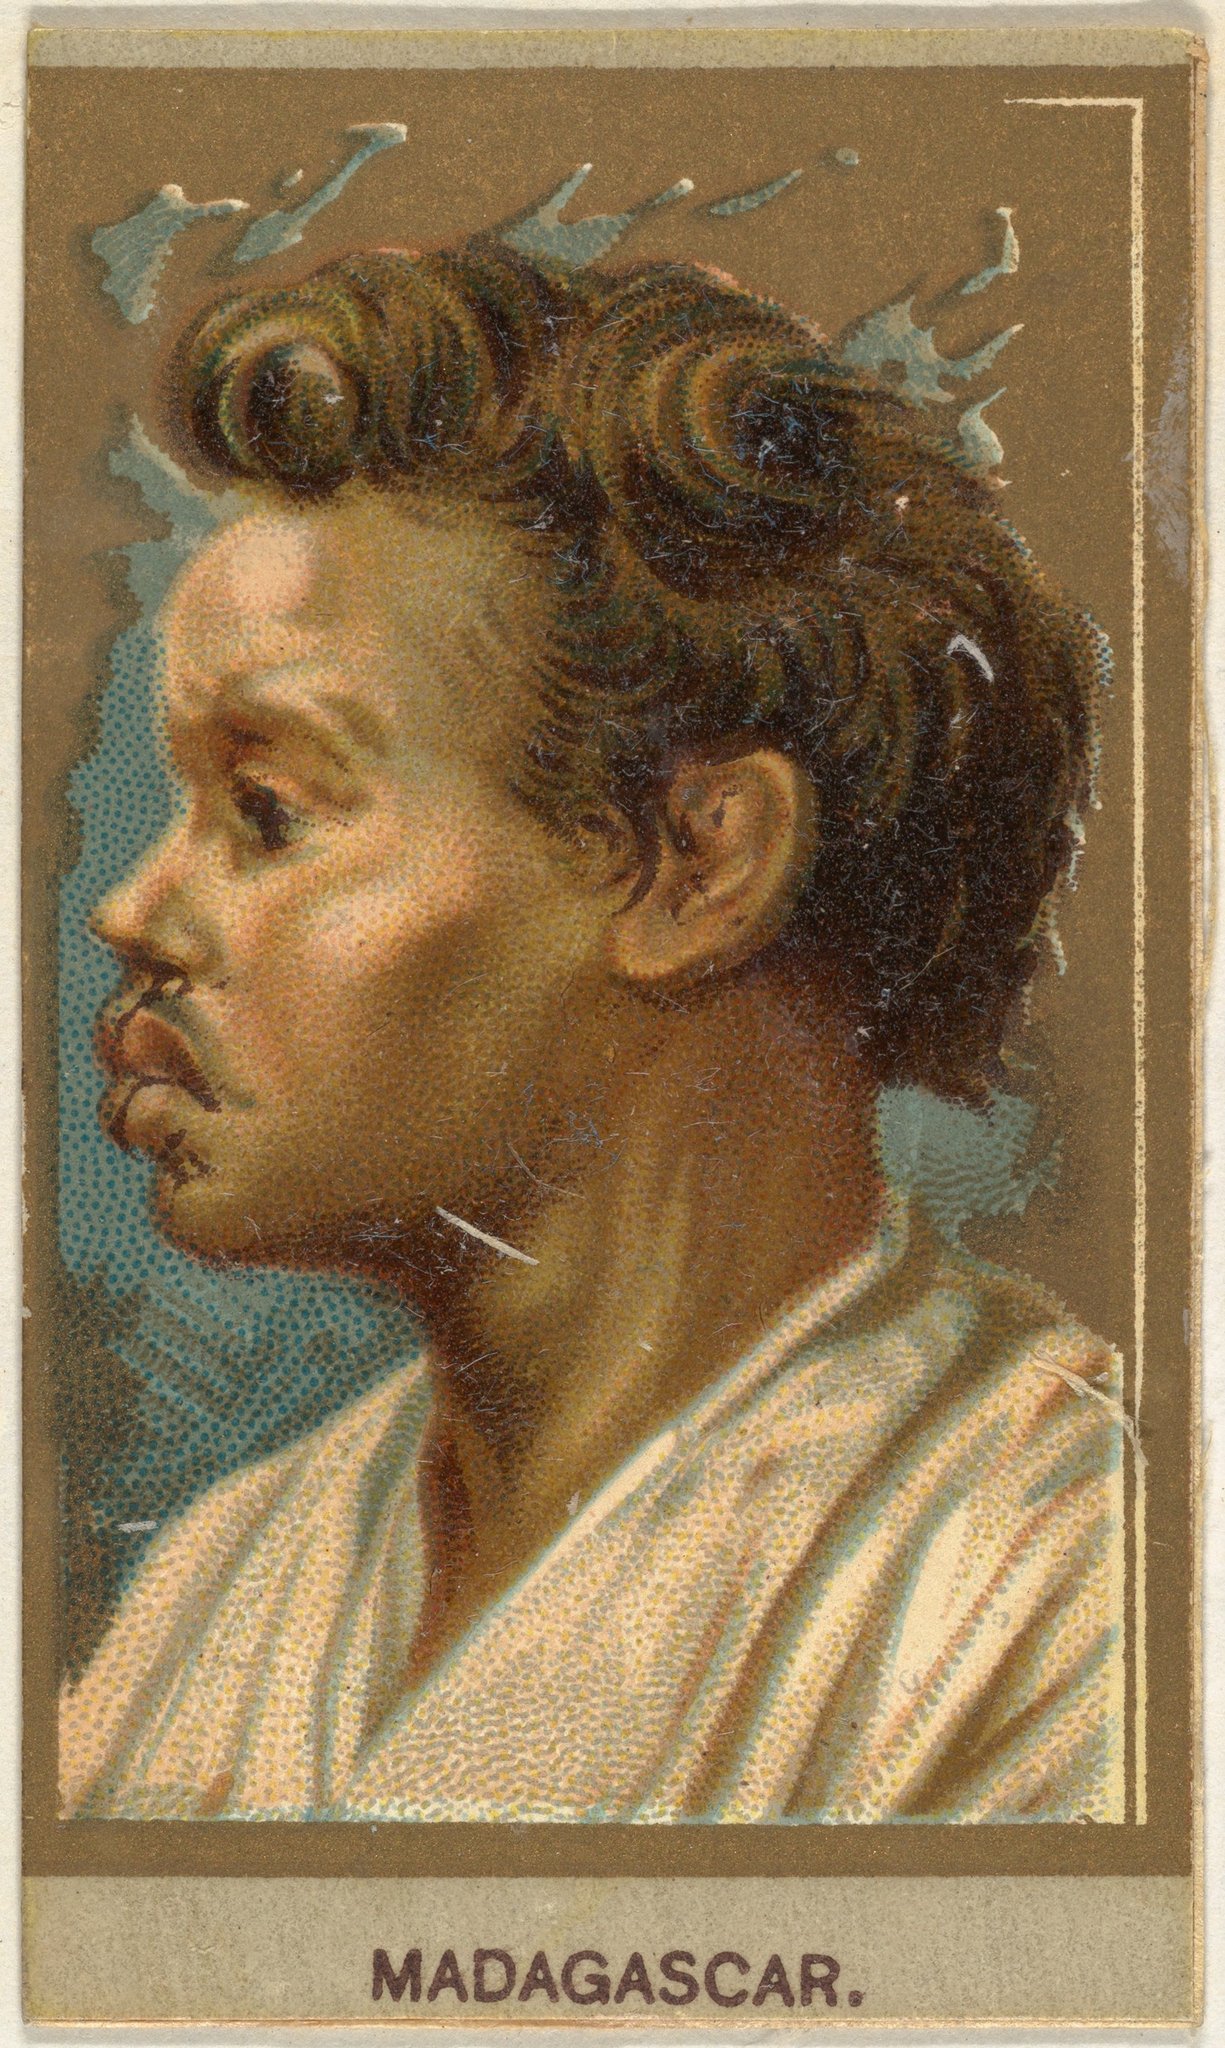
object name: print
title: Madagascar, from the Races of Mankind series (T181) issued by Abdul Cigarettes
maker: abdul cigarettes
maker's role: publisher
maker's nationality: american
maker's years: 1881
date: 1881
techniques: color lithograph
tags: men,profiles